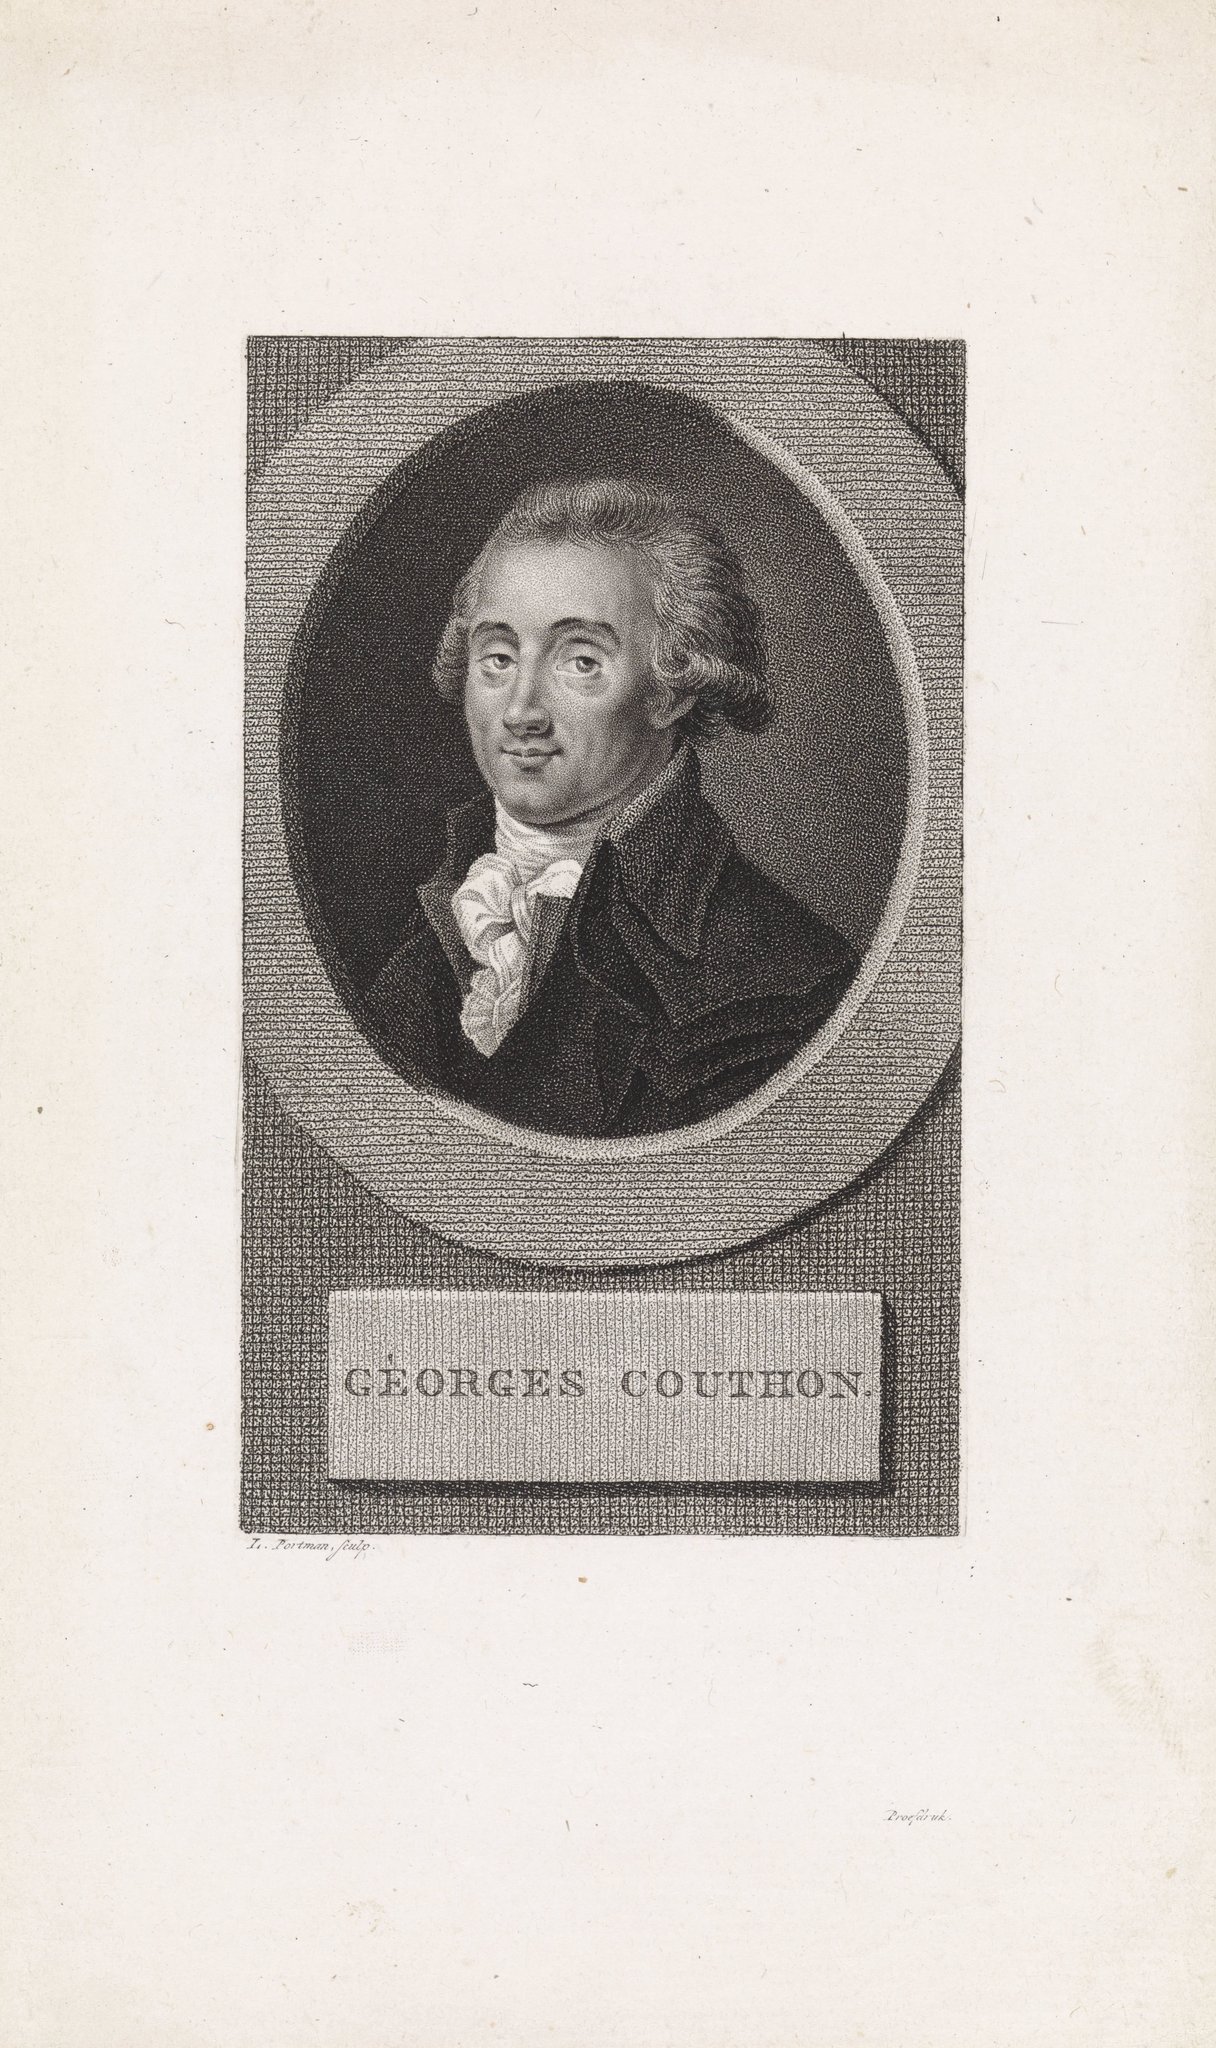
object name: print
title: Portret van Georges Auguste Couthon, Franse politicus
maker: ludwig gottlieb portman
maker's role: print maker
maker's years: 1772-1828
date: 1804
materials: paper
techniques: stippled etching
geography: amsterdam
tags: advocaat, georges auguste couthon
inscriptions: collector's mark: Lugt 2228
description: Prent ook gebruikt als illustratie in: Tafereelen van de staatsomwenteling in Frankrijk, deel 18, p. 168. Amsterdam: Johannes Allart, 1804.